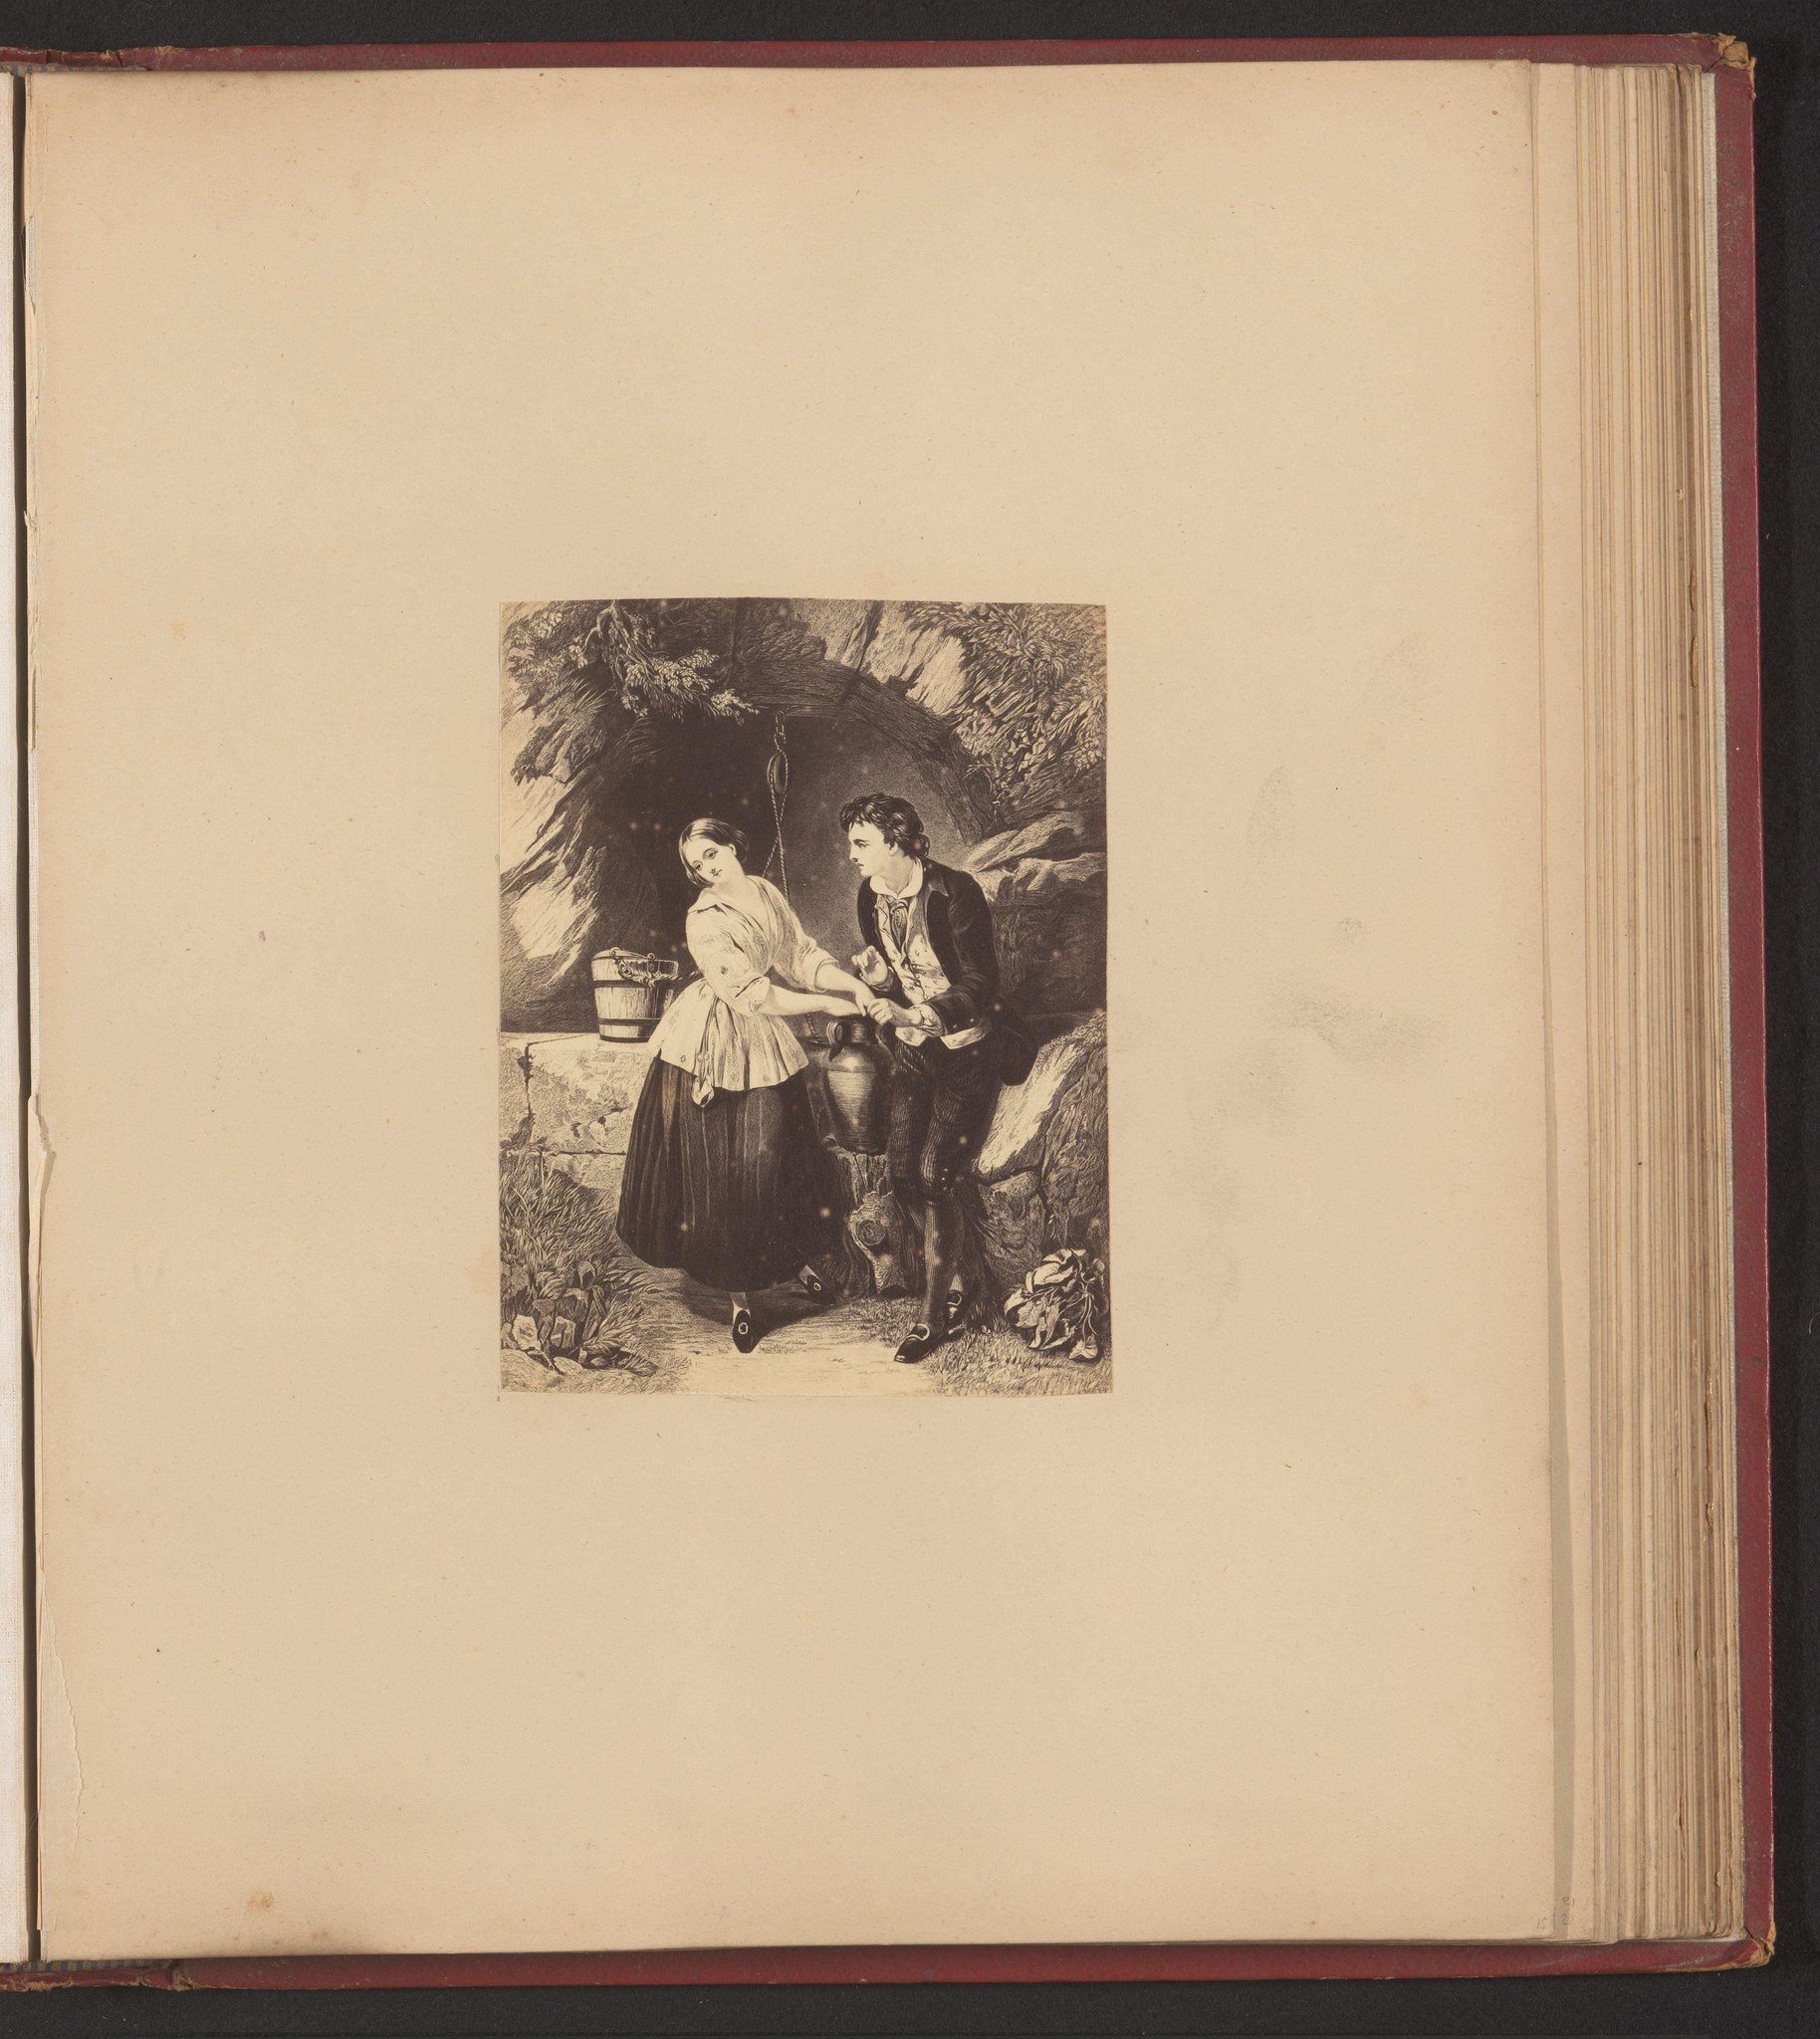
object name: album leaf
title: Fotoreproductie van een prent met man en vrouw bij een waterput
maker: Anonymous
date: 1875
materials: photographic support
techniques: albumen print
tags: well, lovers' meeting